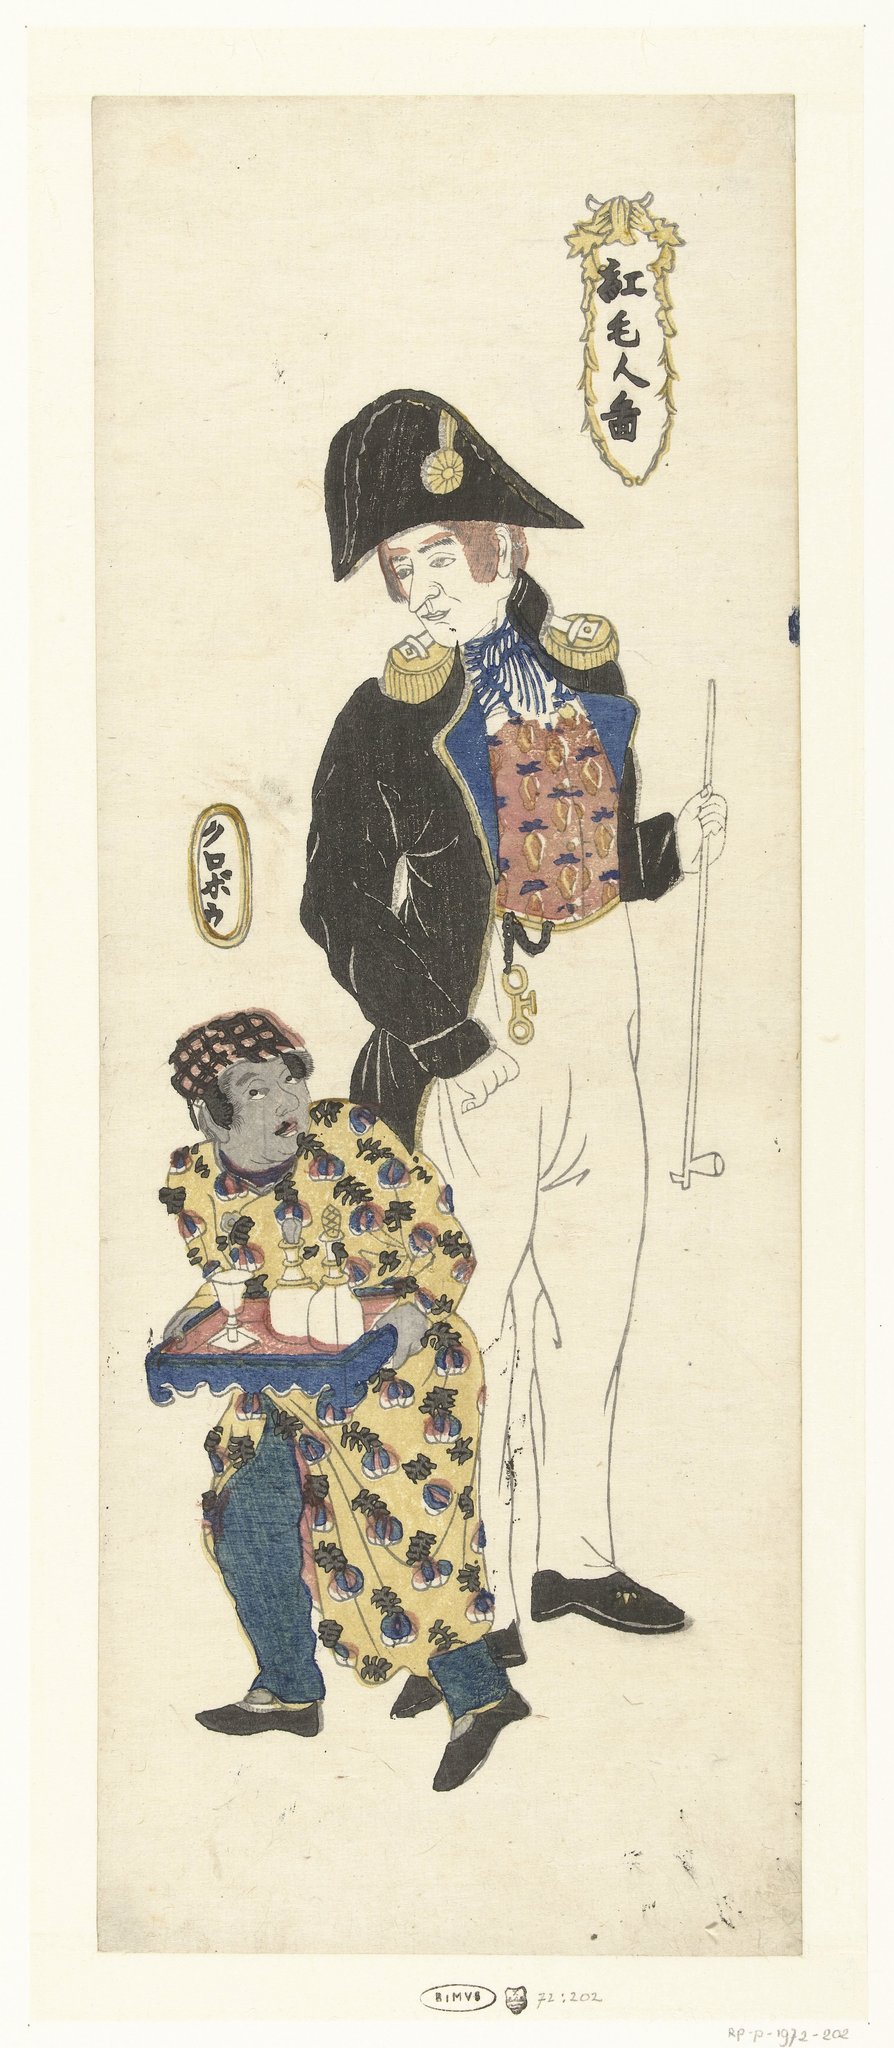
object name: print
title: Portret van een roodharige buitenlander en een zwarte jongen.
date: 1840-1850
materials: paper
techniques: woodcut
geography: nagasaki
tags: standing figure, pipe ~ tobacco, house personnel, servants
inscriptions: collector's mark: Lugt 2228, collector's mark: Lugt 2760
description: Nederlander met lange stenen pijp in rechter hand, kijkend naar Javaanse bediende met dienblad waarop twee karaffen en een glas. (Nagasaki-e)